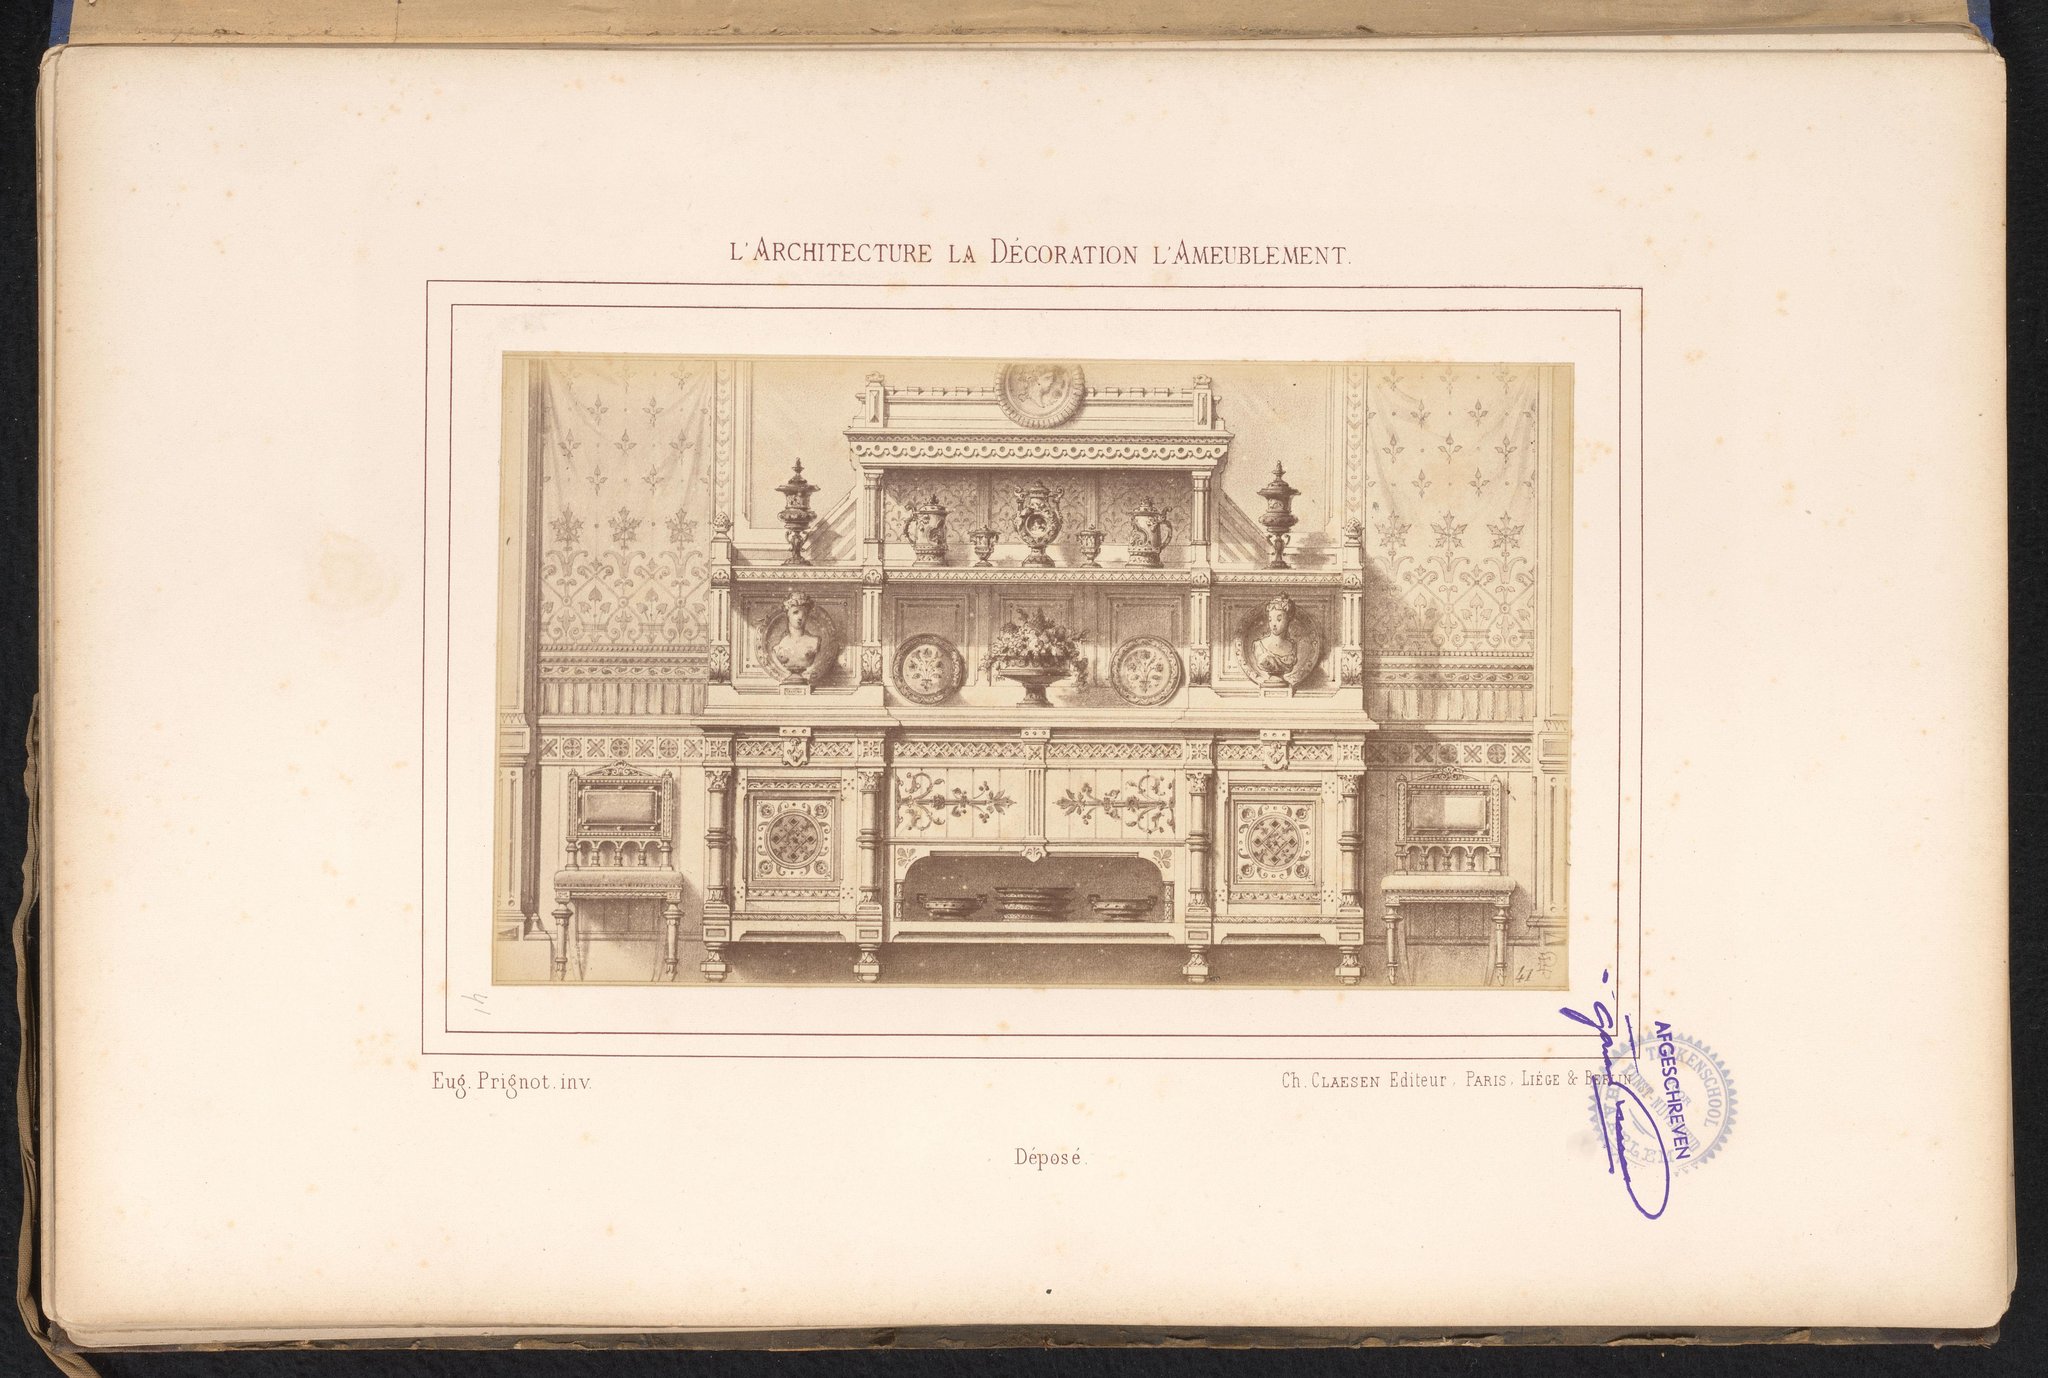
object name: reproduction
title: L'Architecture la Décoration l'Ameublement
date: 1873-1880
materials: cardboard, paper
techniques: albumen print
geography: liège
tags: dinner-service, cupboard, chair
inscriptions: stamp: ‘AFGESCHREVEN/ [...]’, inscription: ‘Déposé’, number: ‘41’, stamp: ‘TEEKENSCHOOL/ VOOR/ KUNST-NIJVERHEID/ HAARLEM’, inscription: ‘Eug. Prignot. inv.’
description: Deze foto maakt deel uit van een omslag met 61 foto's op 61 bladen.